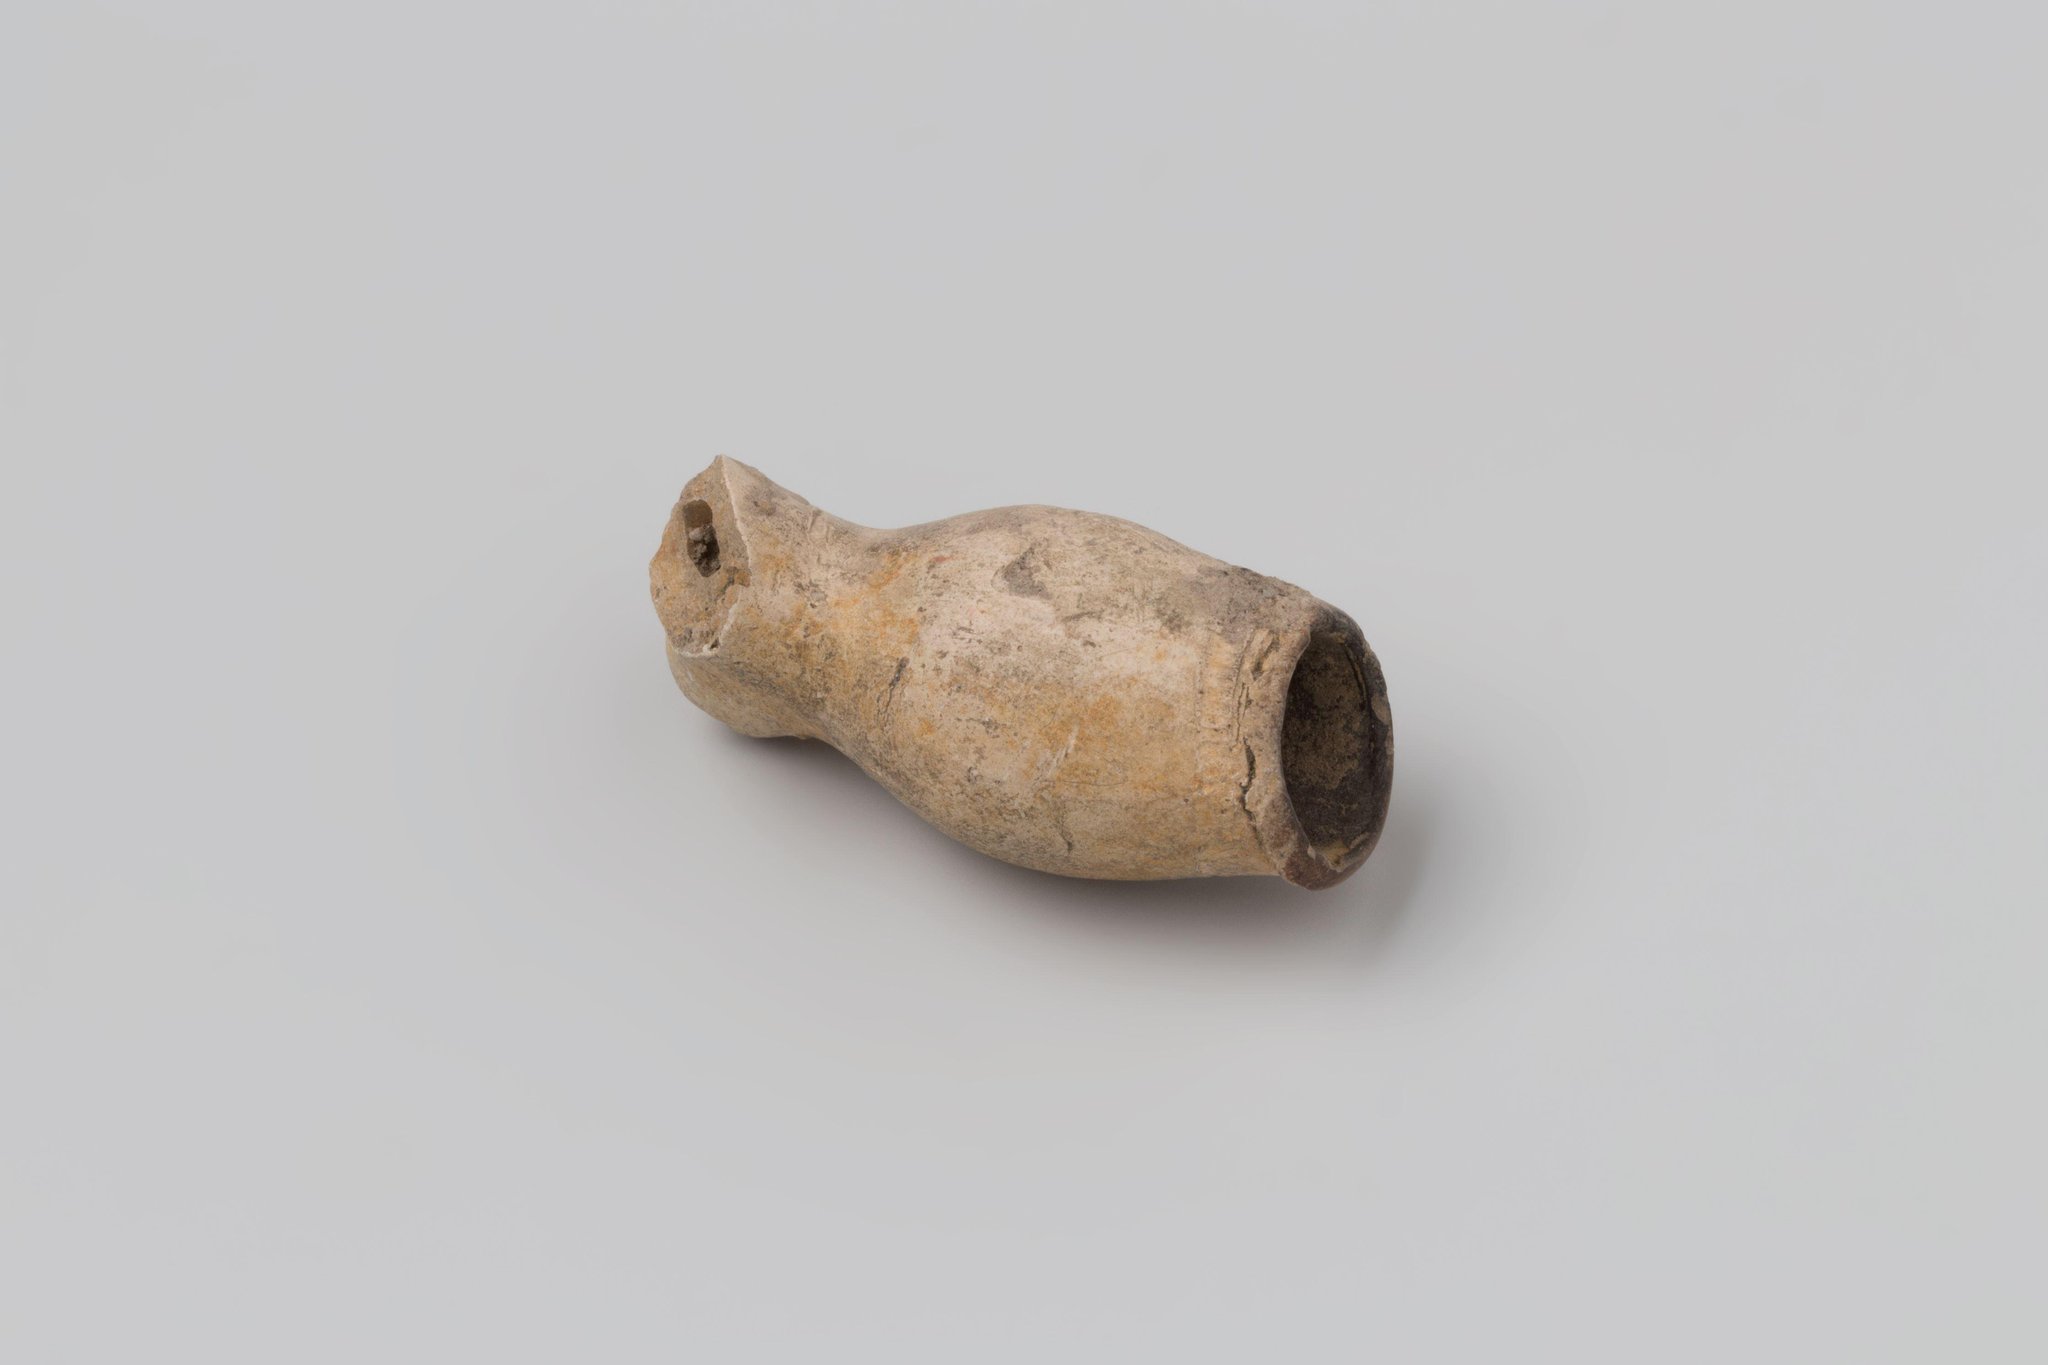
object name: pipe bowl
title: Pijpenkop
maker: Anonymous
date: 1400-1950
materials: clay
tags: zeeuwsche uytkyck